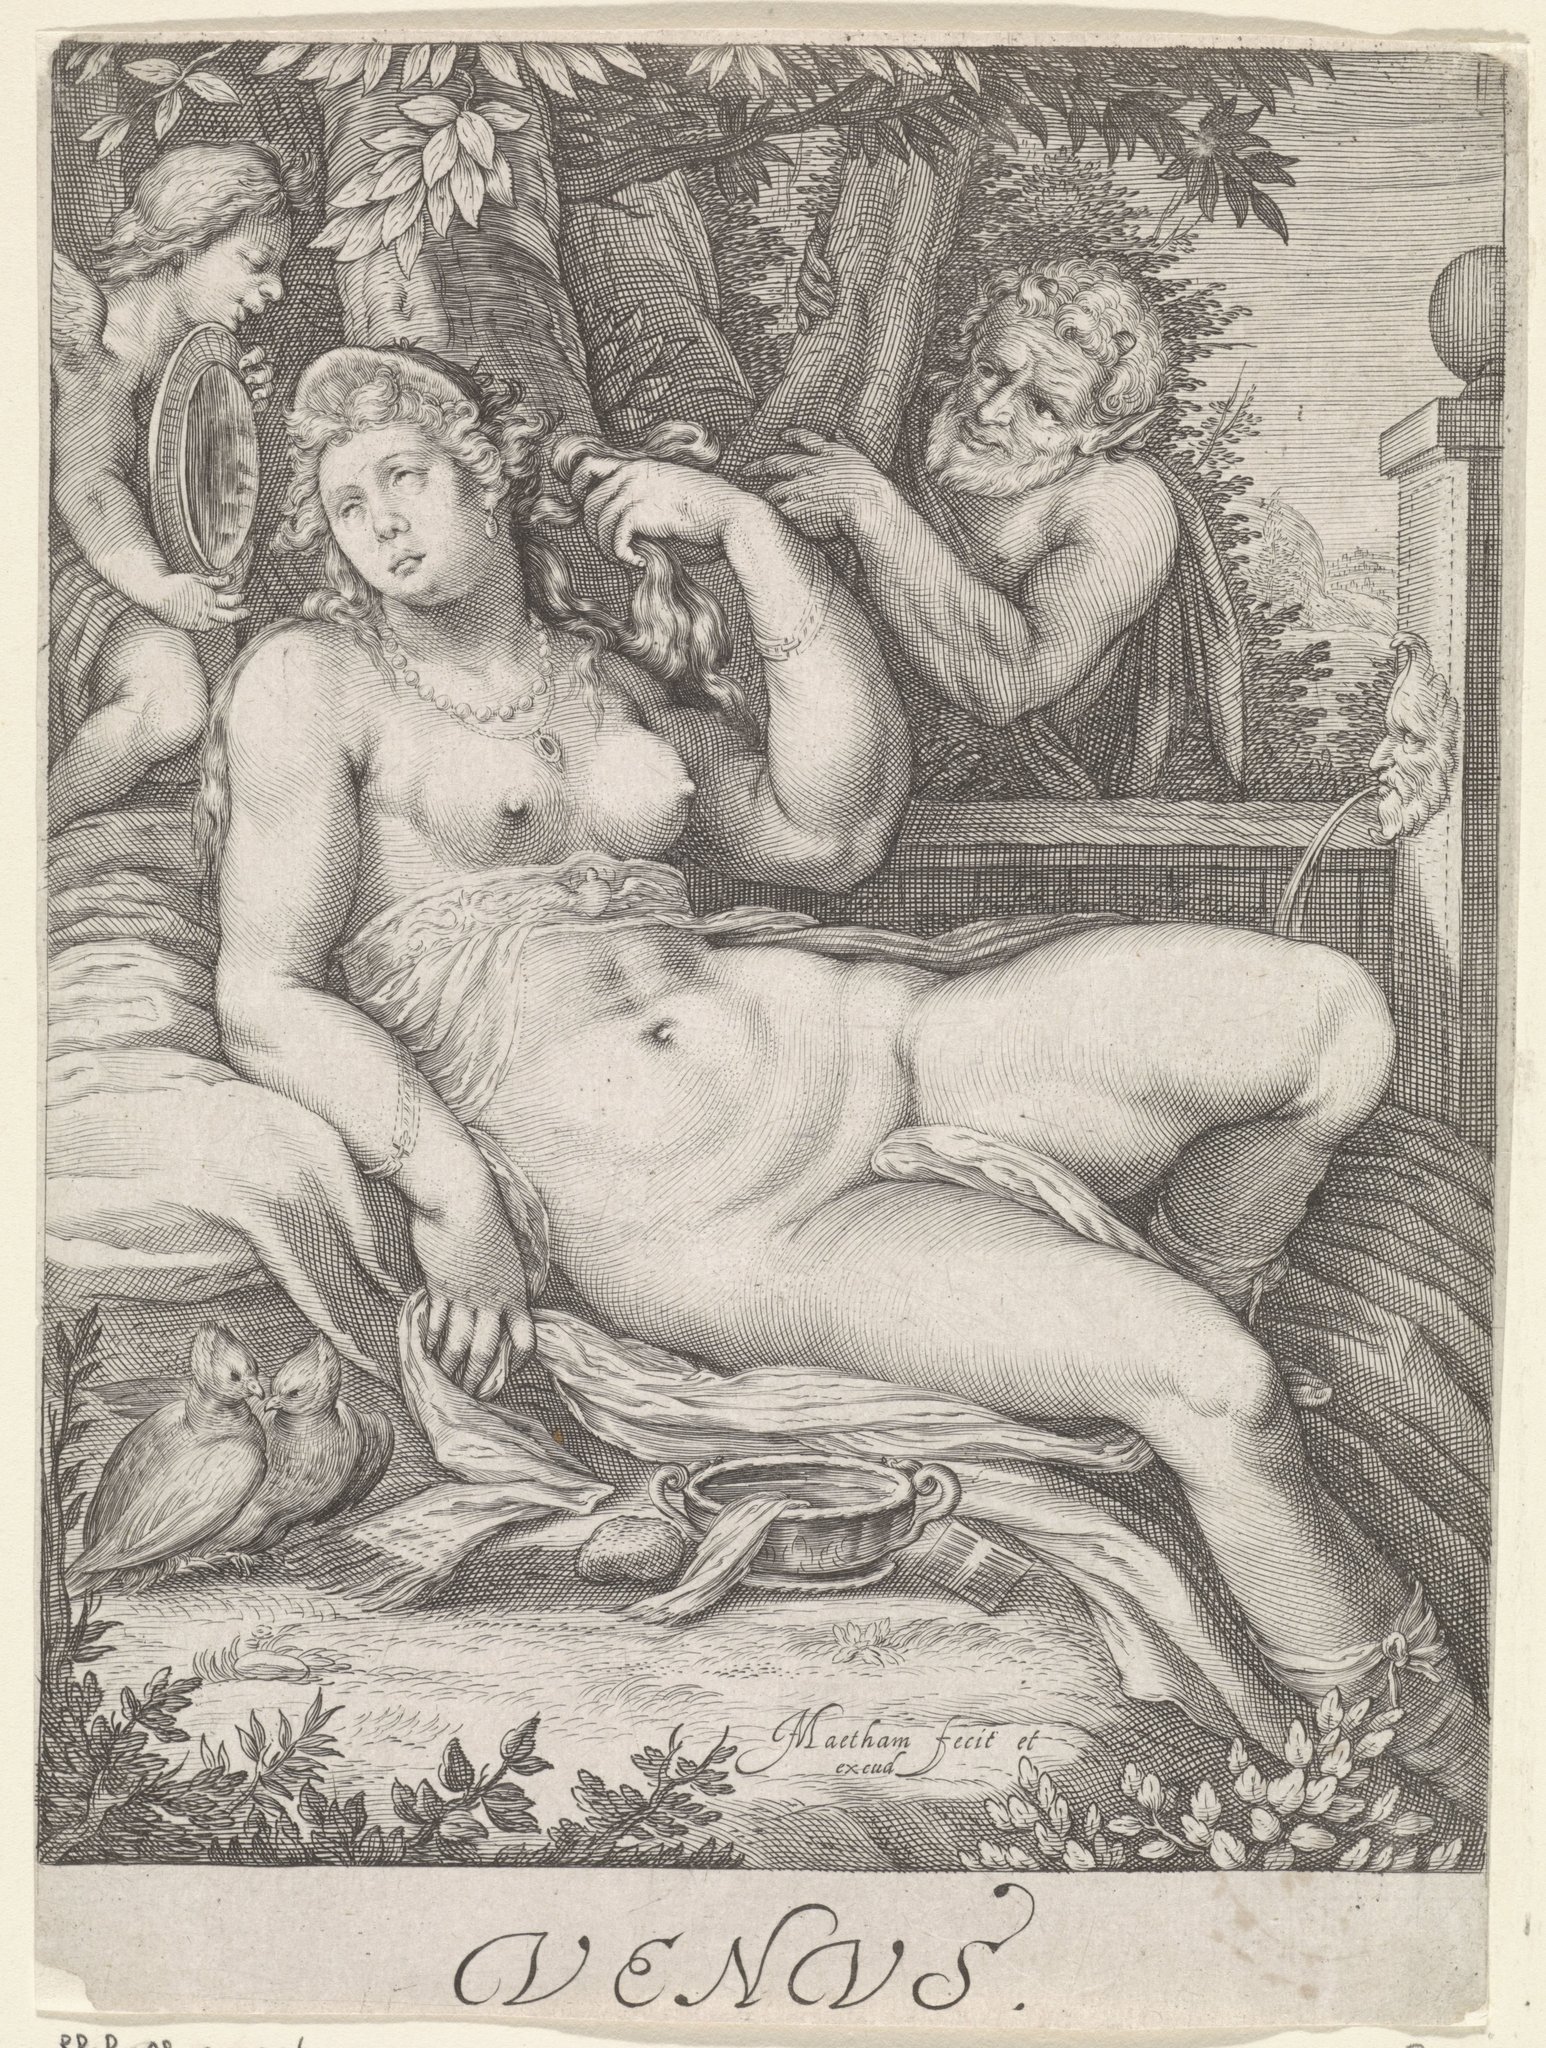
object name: print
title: Venus bespied door een sater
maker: jacob matham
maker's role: draughtsman, print maker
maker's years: 1571-1631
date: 1599-1602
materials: paper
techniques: engraving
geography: haarlem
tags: looking in the mirror; contemplation of own beauty, toilet of venus, satyr(s) (in general)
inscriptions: collector's mark: Lugt 240, signature and address: ‘JMaetham fecit et excud.’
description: Venus bekijkt zichzelf in een spiegel, die opgehouden wordt door Amor. Achter een boom kijkt een sater toe.